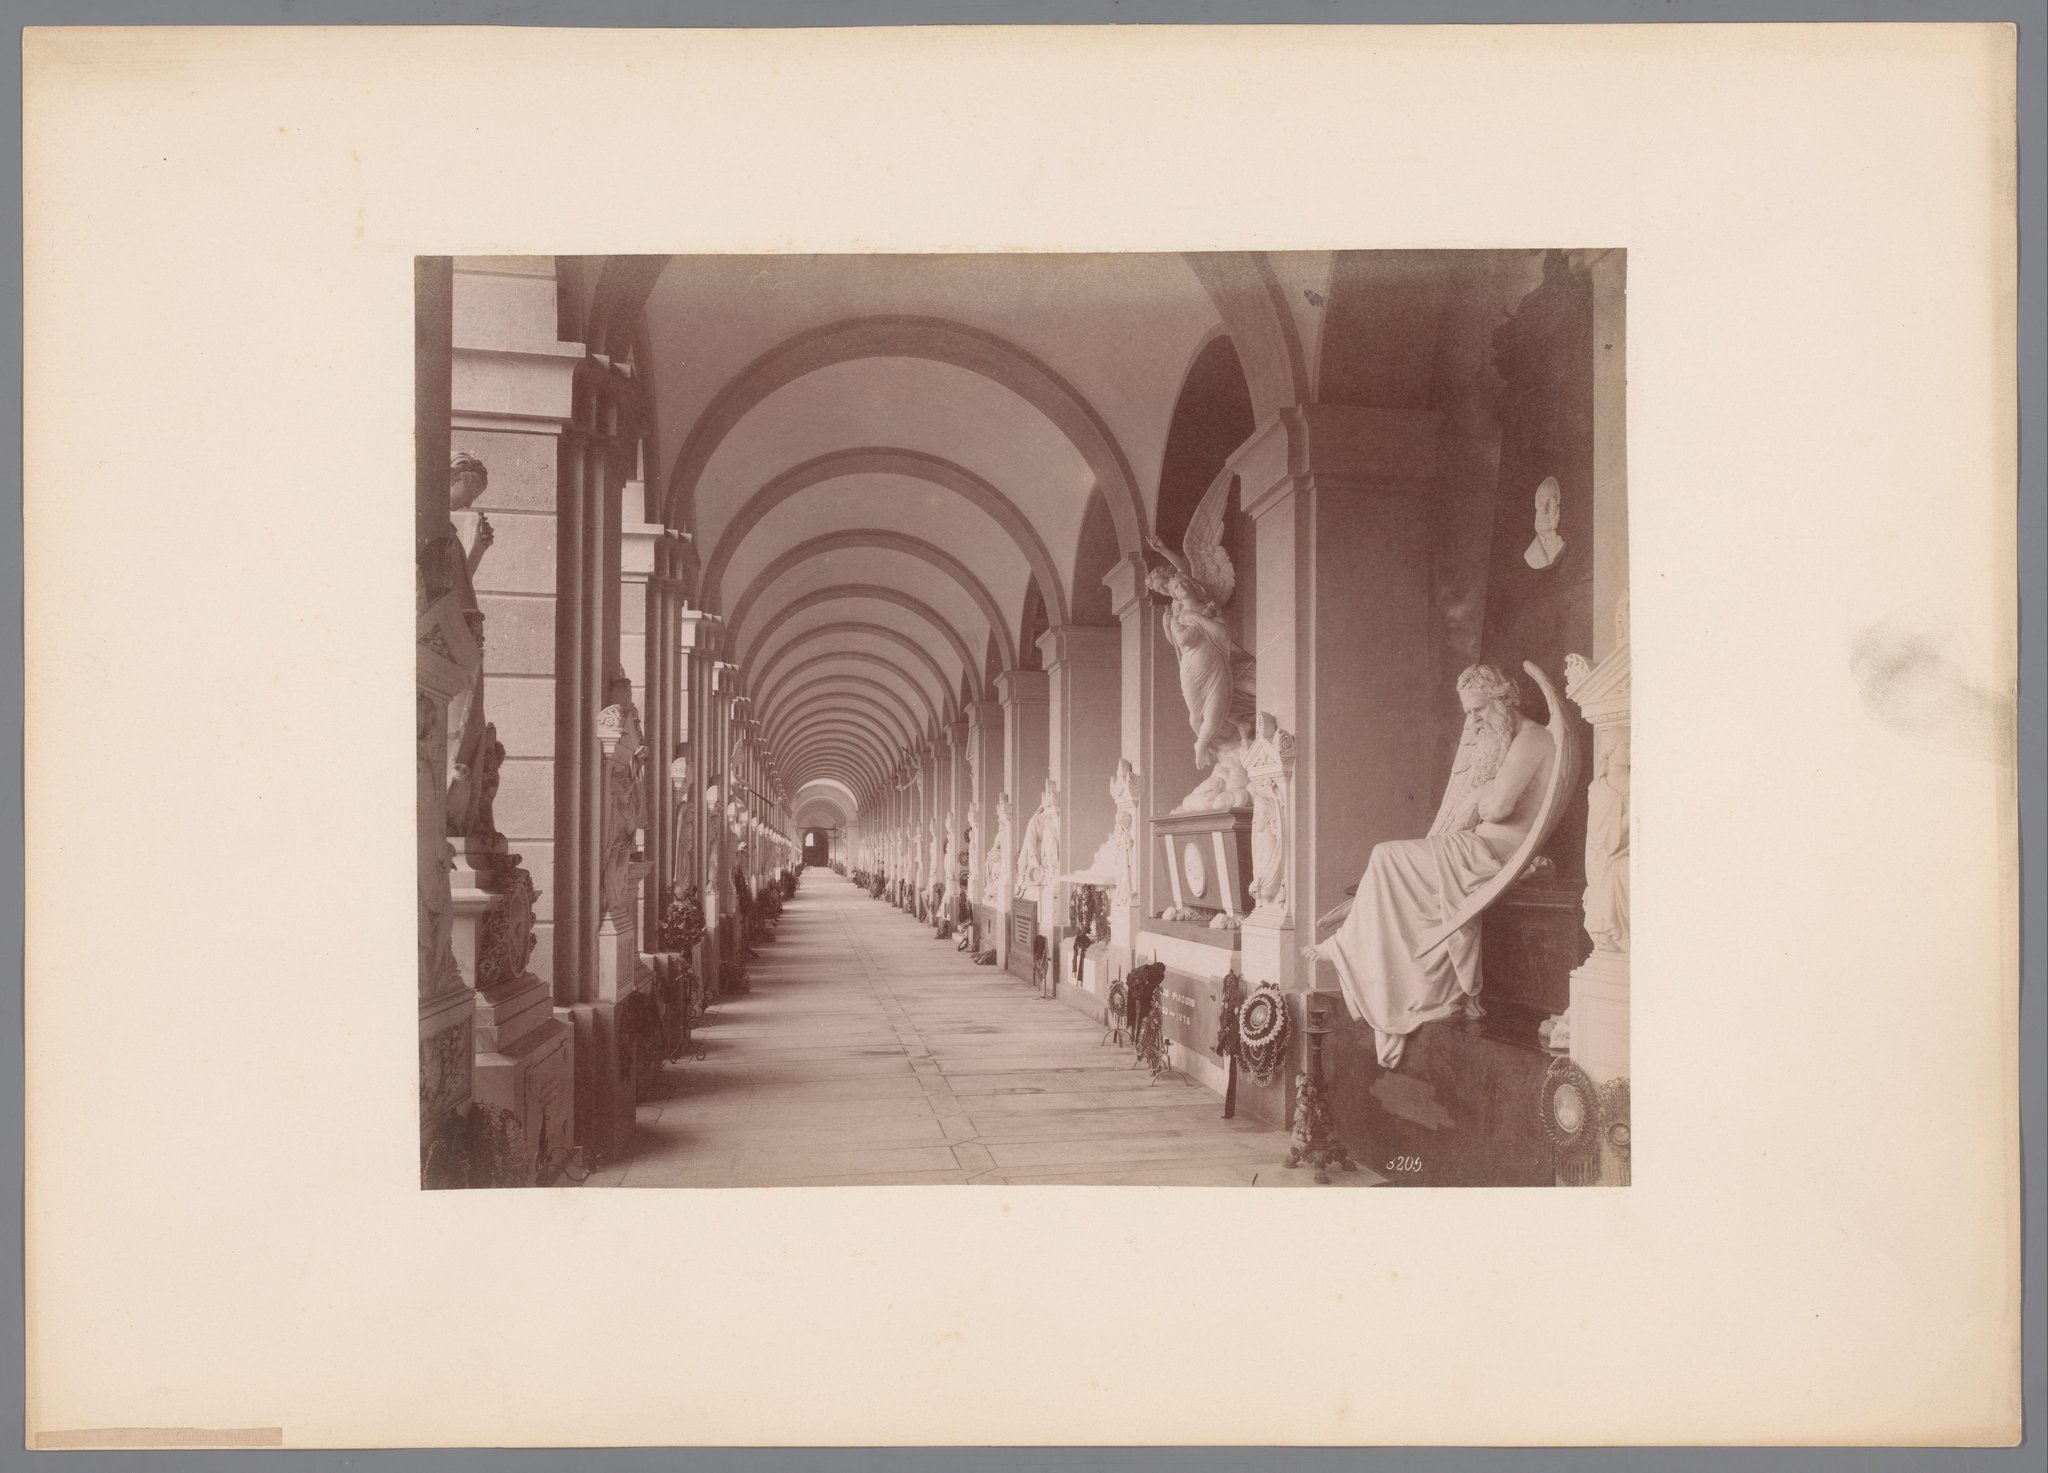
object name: photograph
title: Camposanto. Galeria Interiore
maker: alfredo noack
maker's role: fotograaf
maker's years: 1833-1895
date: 1858-1893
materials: cardboard, paper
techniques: albumen print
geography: genoa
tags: gallery of sculptures, gravestone, tombstone, cemetery, park-like burying ground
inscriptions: number: ‘3205.’